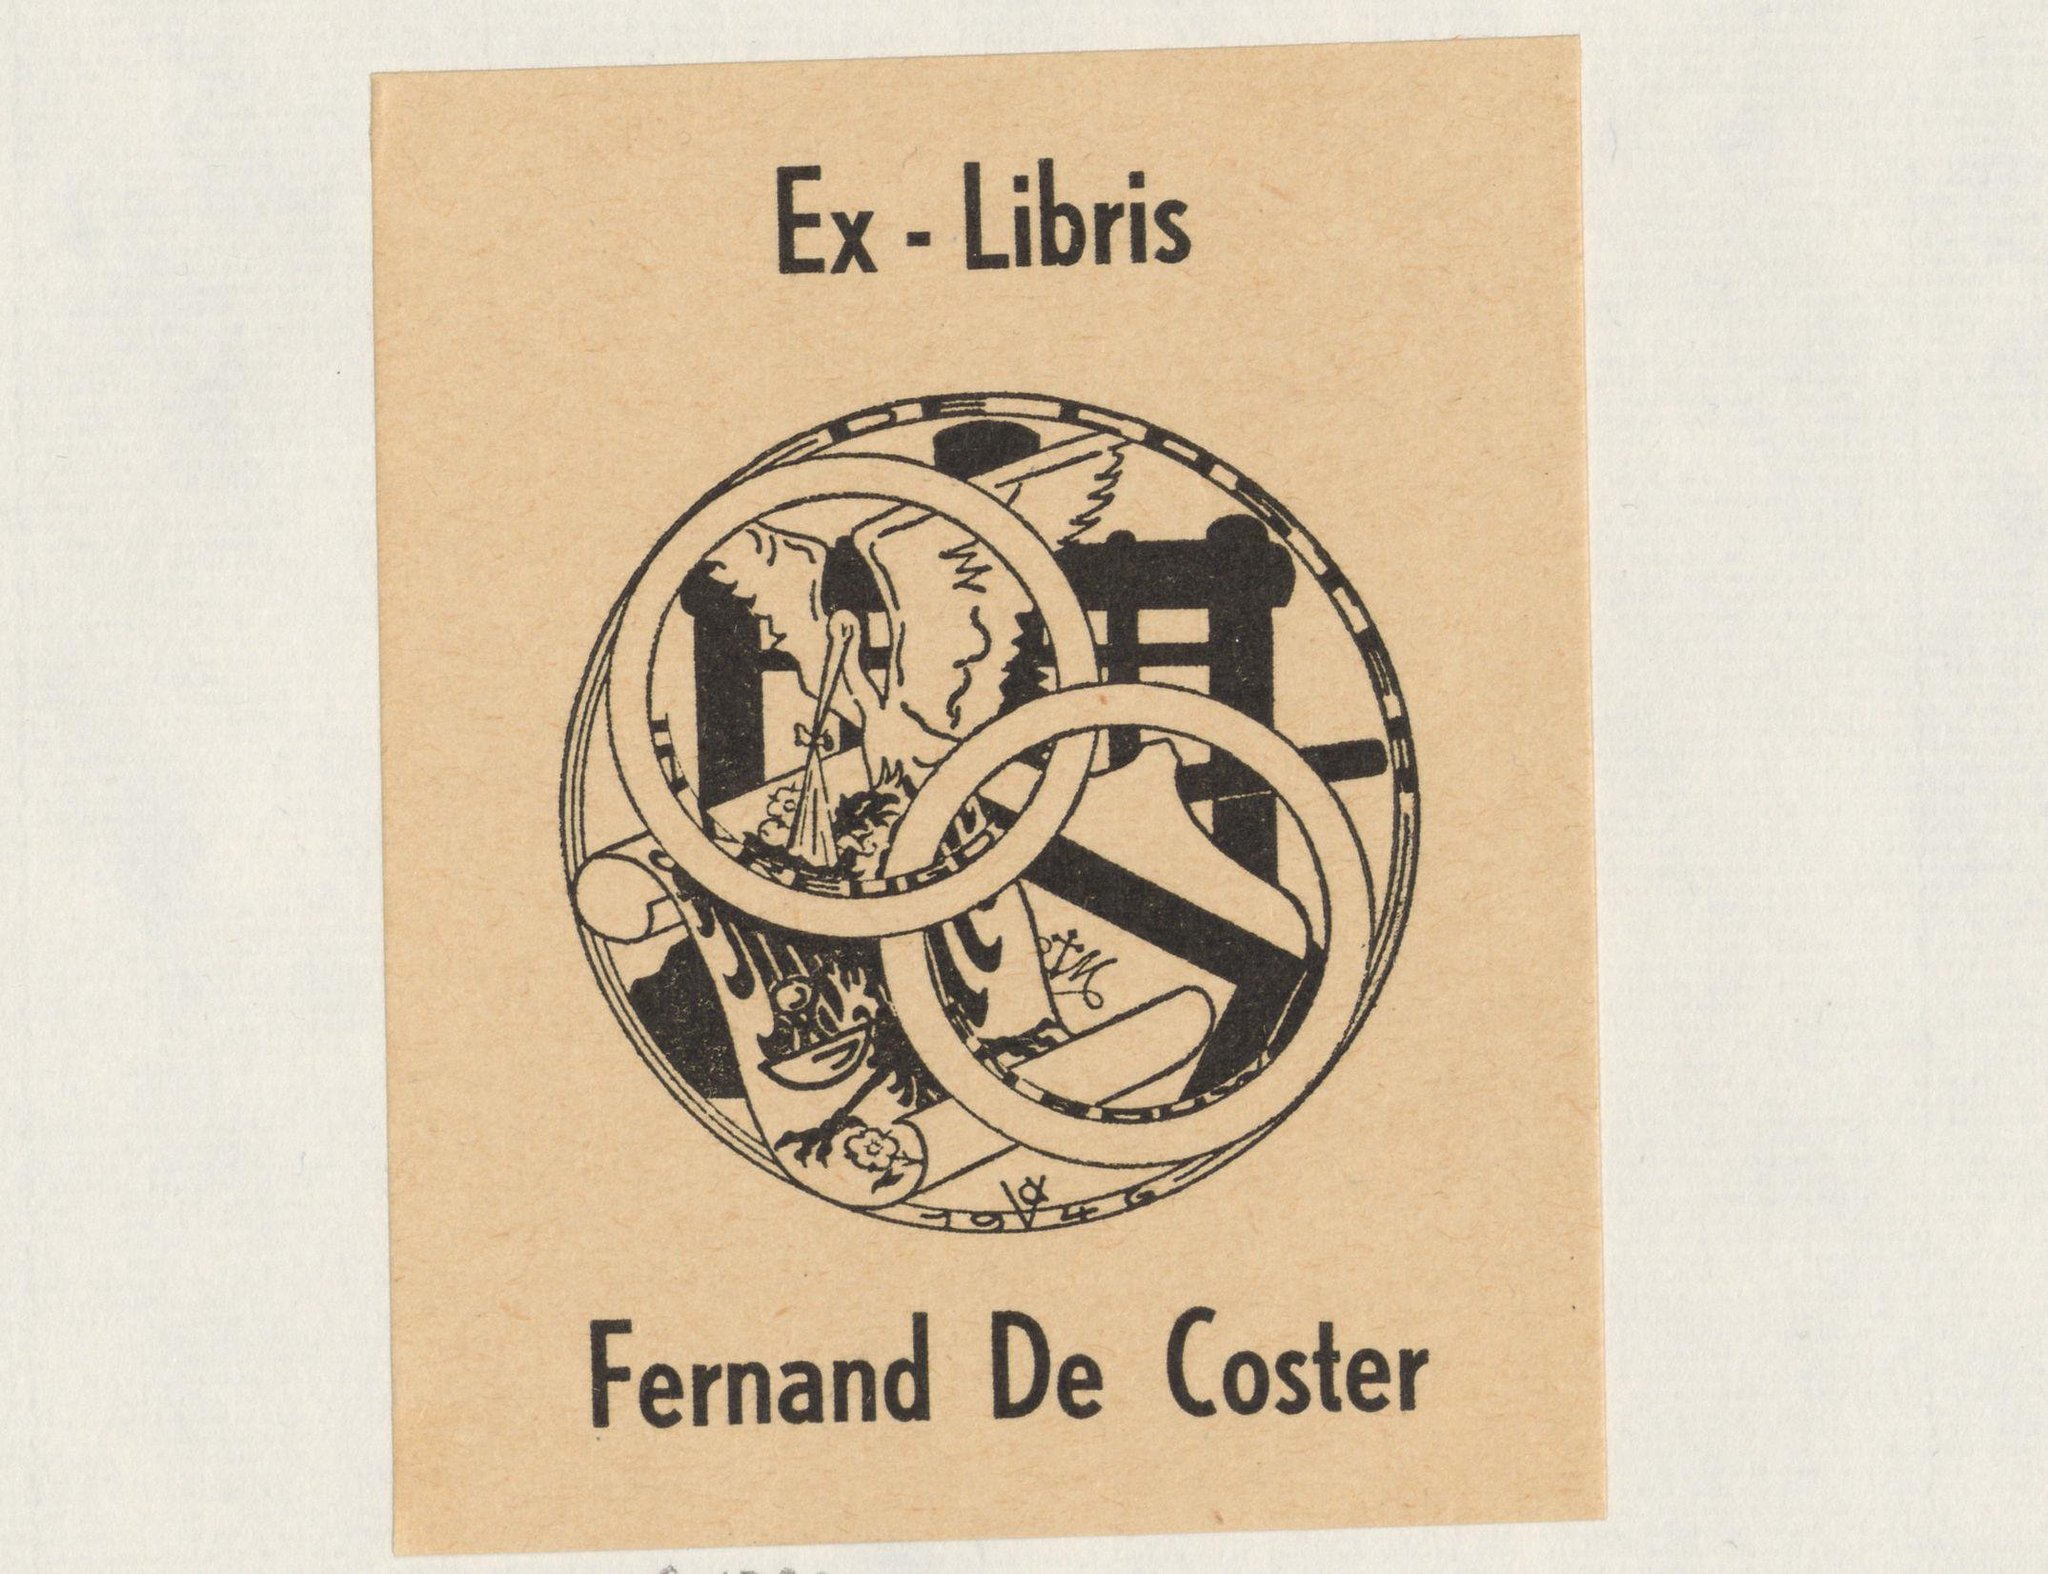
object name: bookplate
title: In vreugd en rouw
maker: Anonymous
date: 1946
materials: paper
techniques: printing block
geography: belgium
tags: shore-birds and wading-birds: stork, armorial bearing, heraldry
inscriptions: date